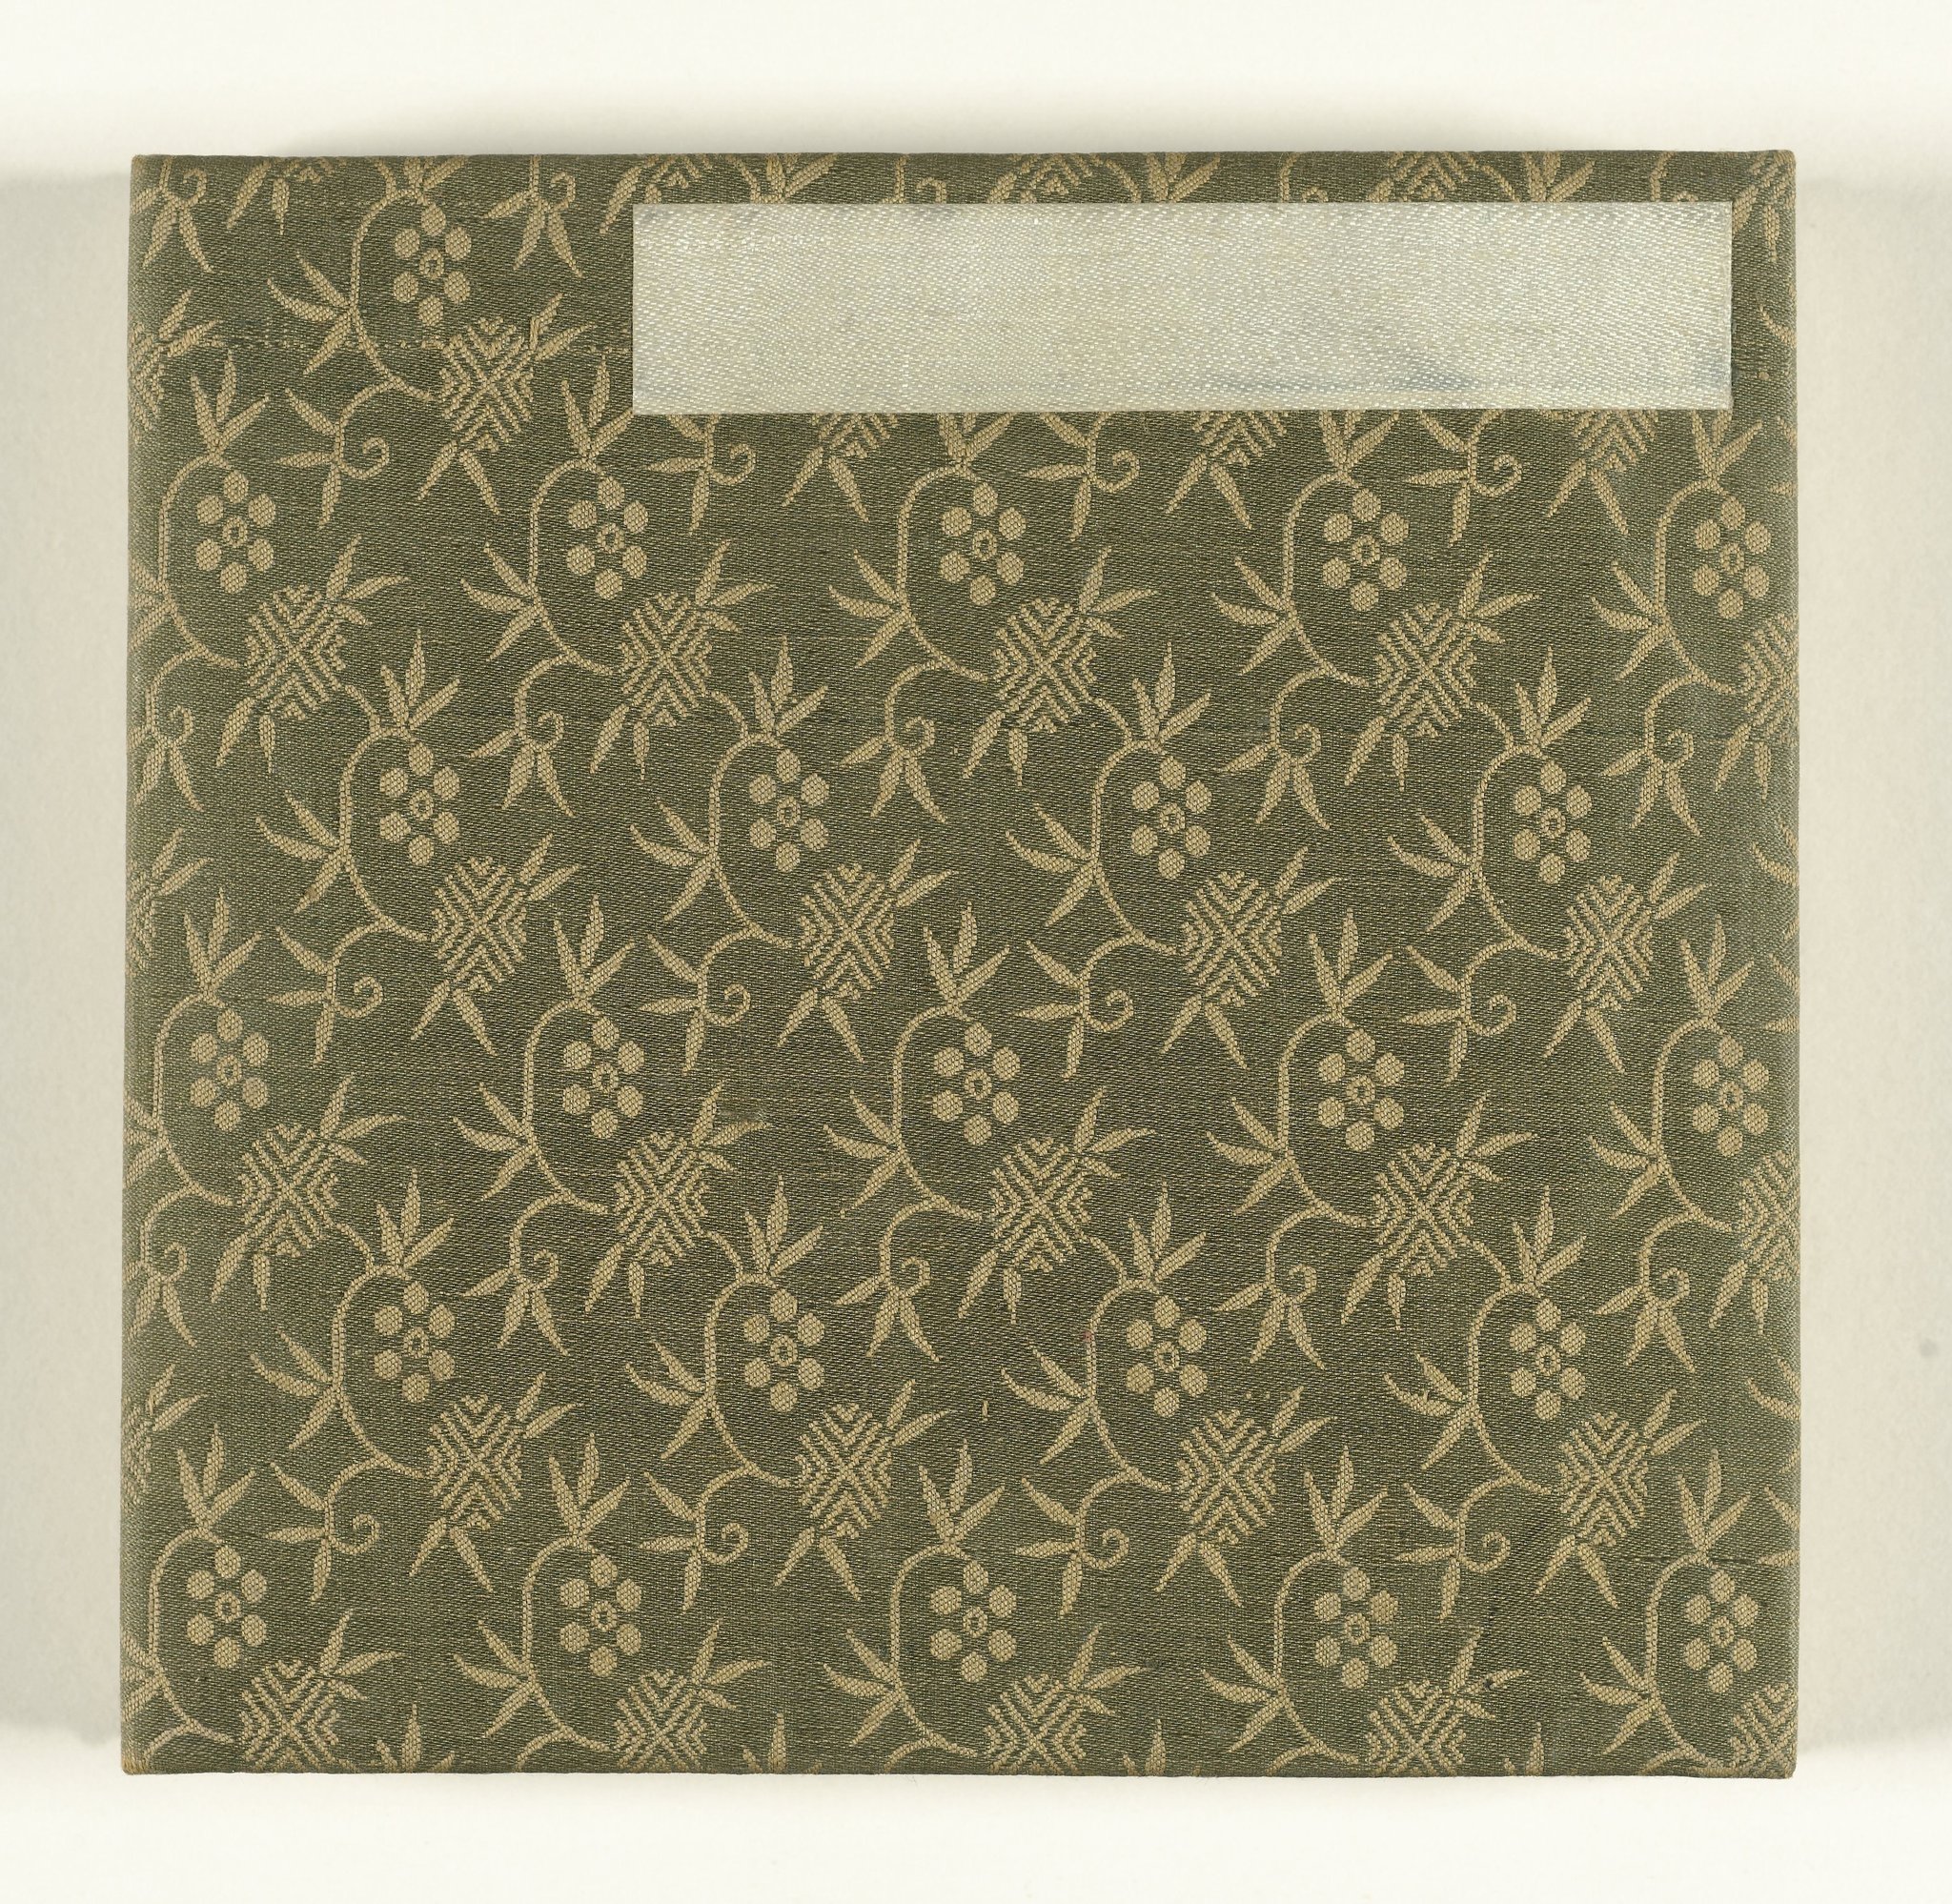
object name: album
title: Album amicorum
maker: Anonymous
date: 1905-1909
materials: paper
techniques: drawing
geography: japan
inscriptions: collector's mark: Lugt 2228